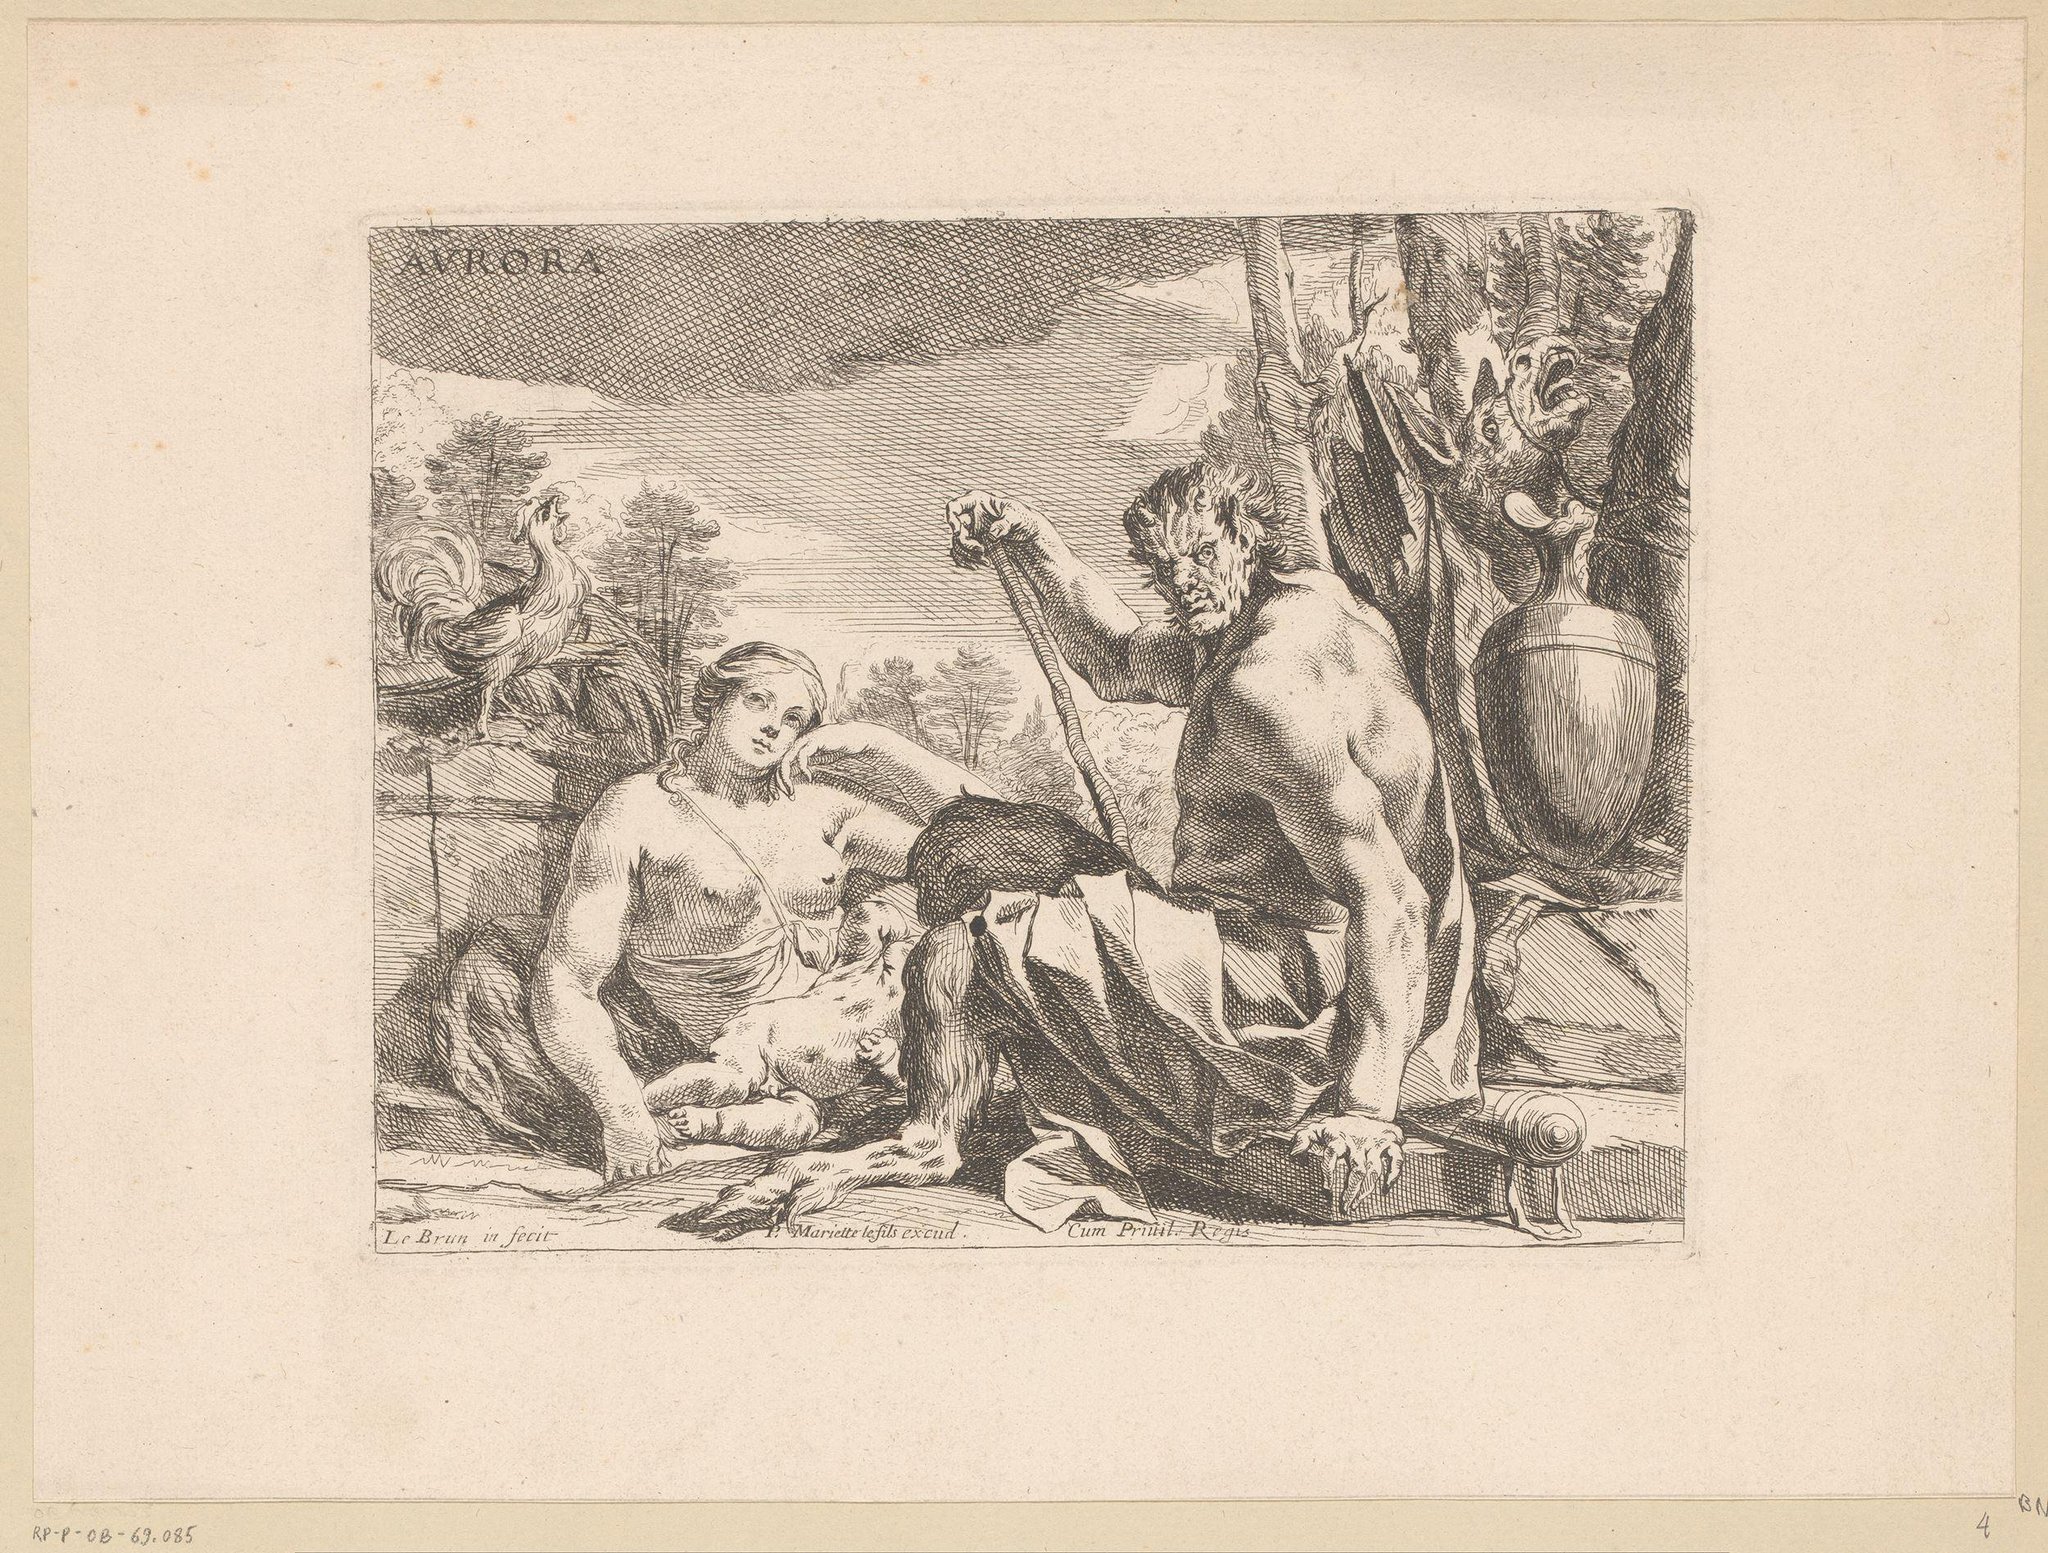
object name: print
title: Personificatie van verschillende tijdstippen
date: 1640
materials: paper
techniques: engraving, etching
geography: paris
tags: ass, donkey, maenad(s), female bacchant(es), satyr(s) (in general), personification of the morning, 'aurora'; 'aurora' (ripa)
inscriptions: collector's mark: Lugt 240